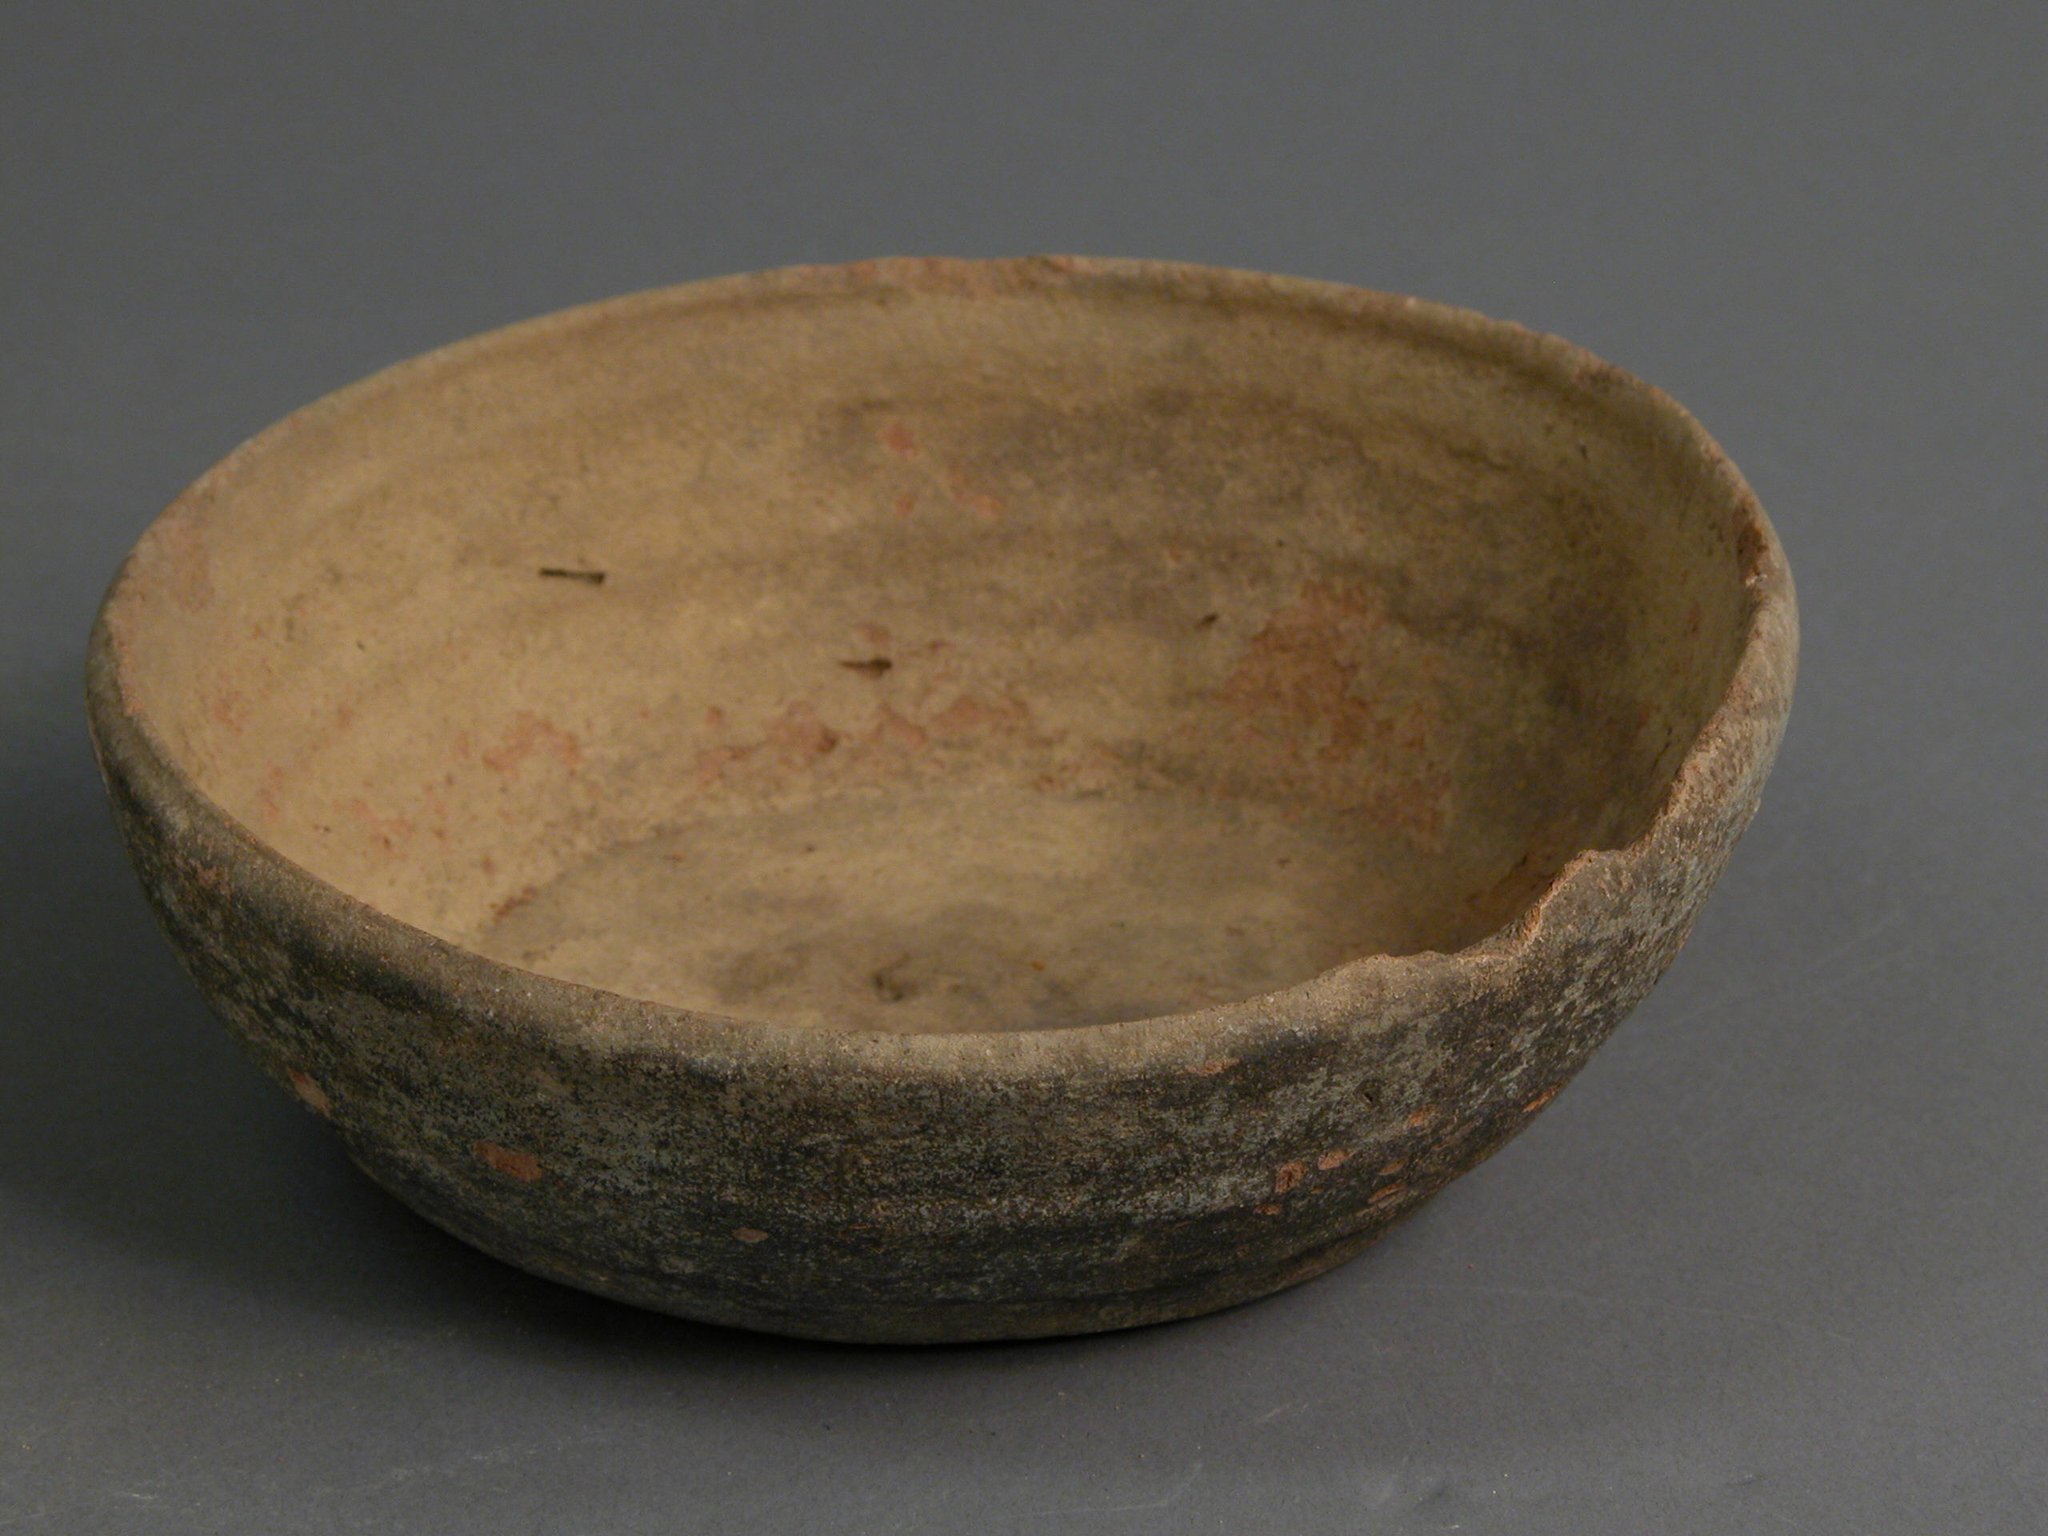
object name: bowl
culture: coptic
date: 301-700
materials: earthenware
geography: egypt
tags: bowls